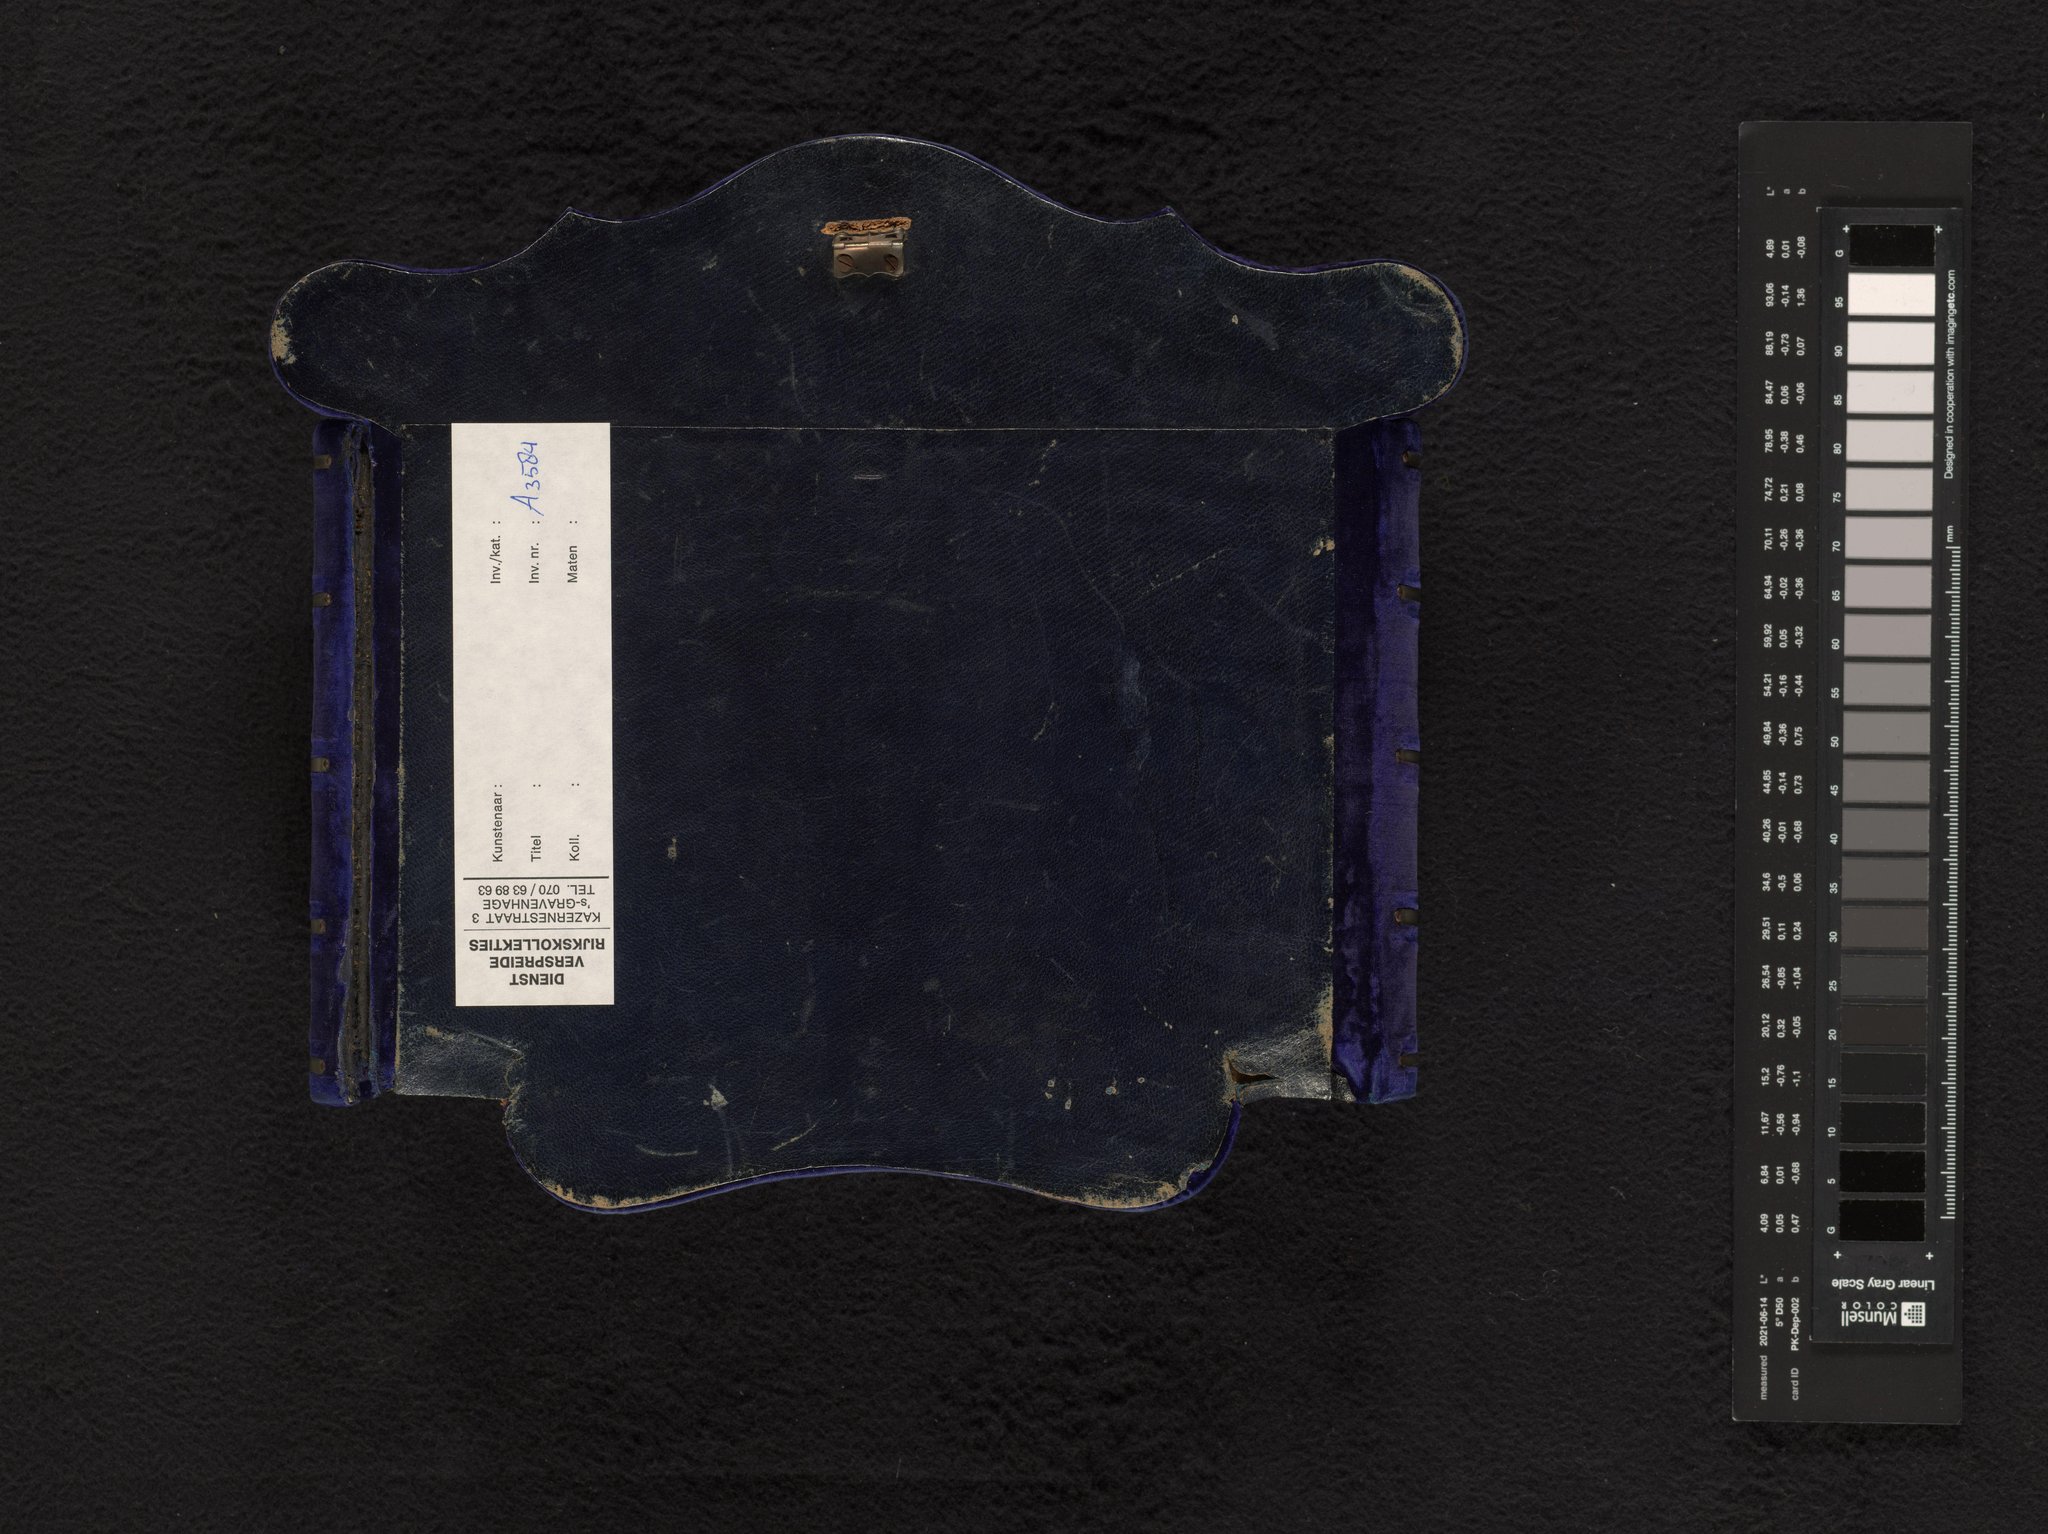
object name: carte de visite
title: Portret van een zittende vrouw en een staand meisje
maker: abel bordéria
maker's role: fotograaf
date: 1860-1900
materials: cardboard, photographic support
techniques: albumen print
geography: reims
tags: sitting figure - aa - female human figure, historical persons - bb - woman, girl (child between toddler and youth)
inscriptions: inscription: ‘Lambertypie/ Chromotypie/ Brevetée/ S.G.D.G./ A. Bordéria/ Atelier/ Place/ Drouet d'Erlon,/ 60/ Reims./ Tous les Clichés sont conservés.’